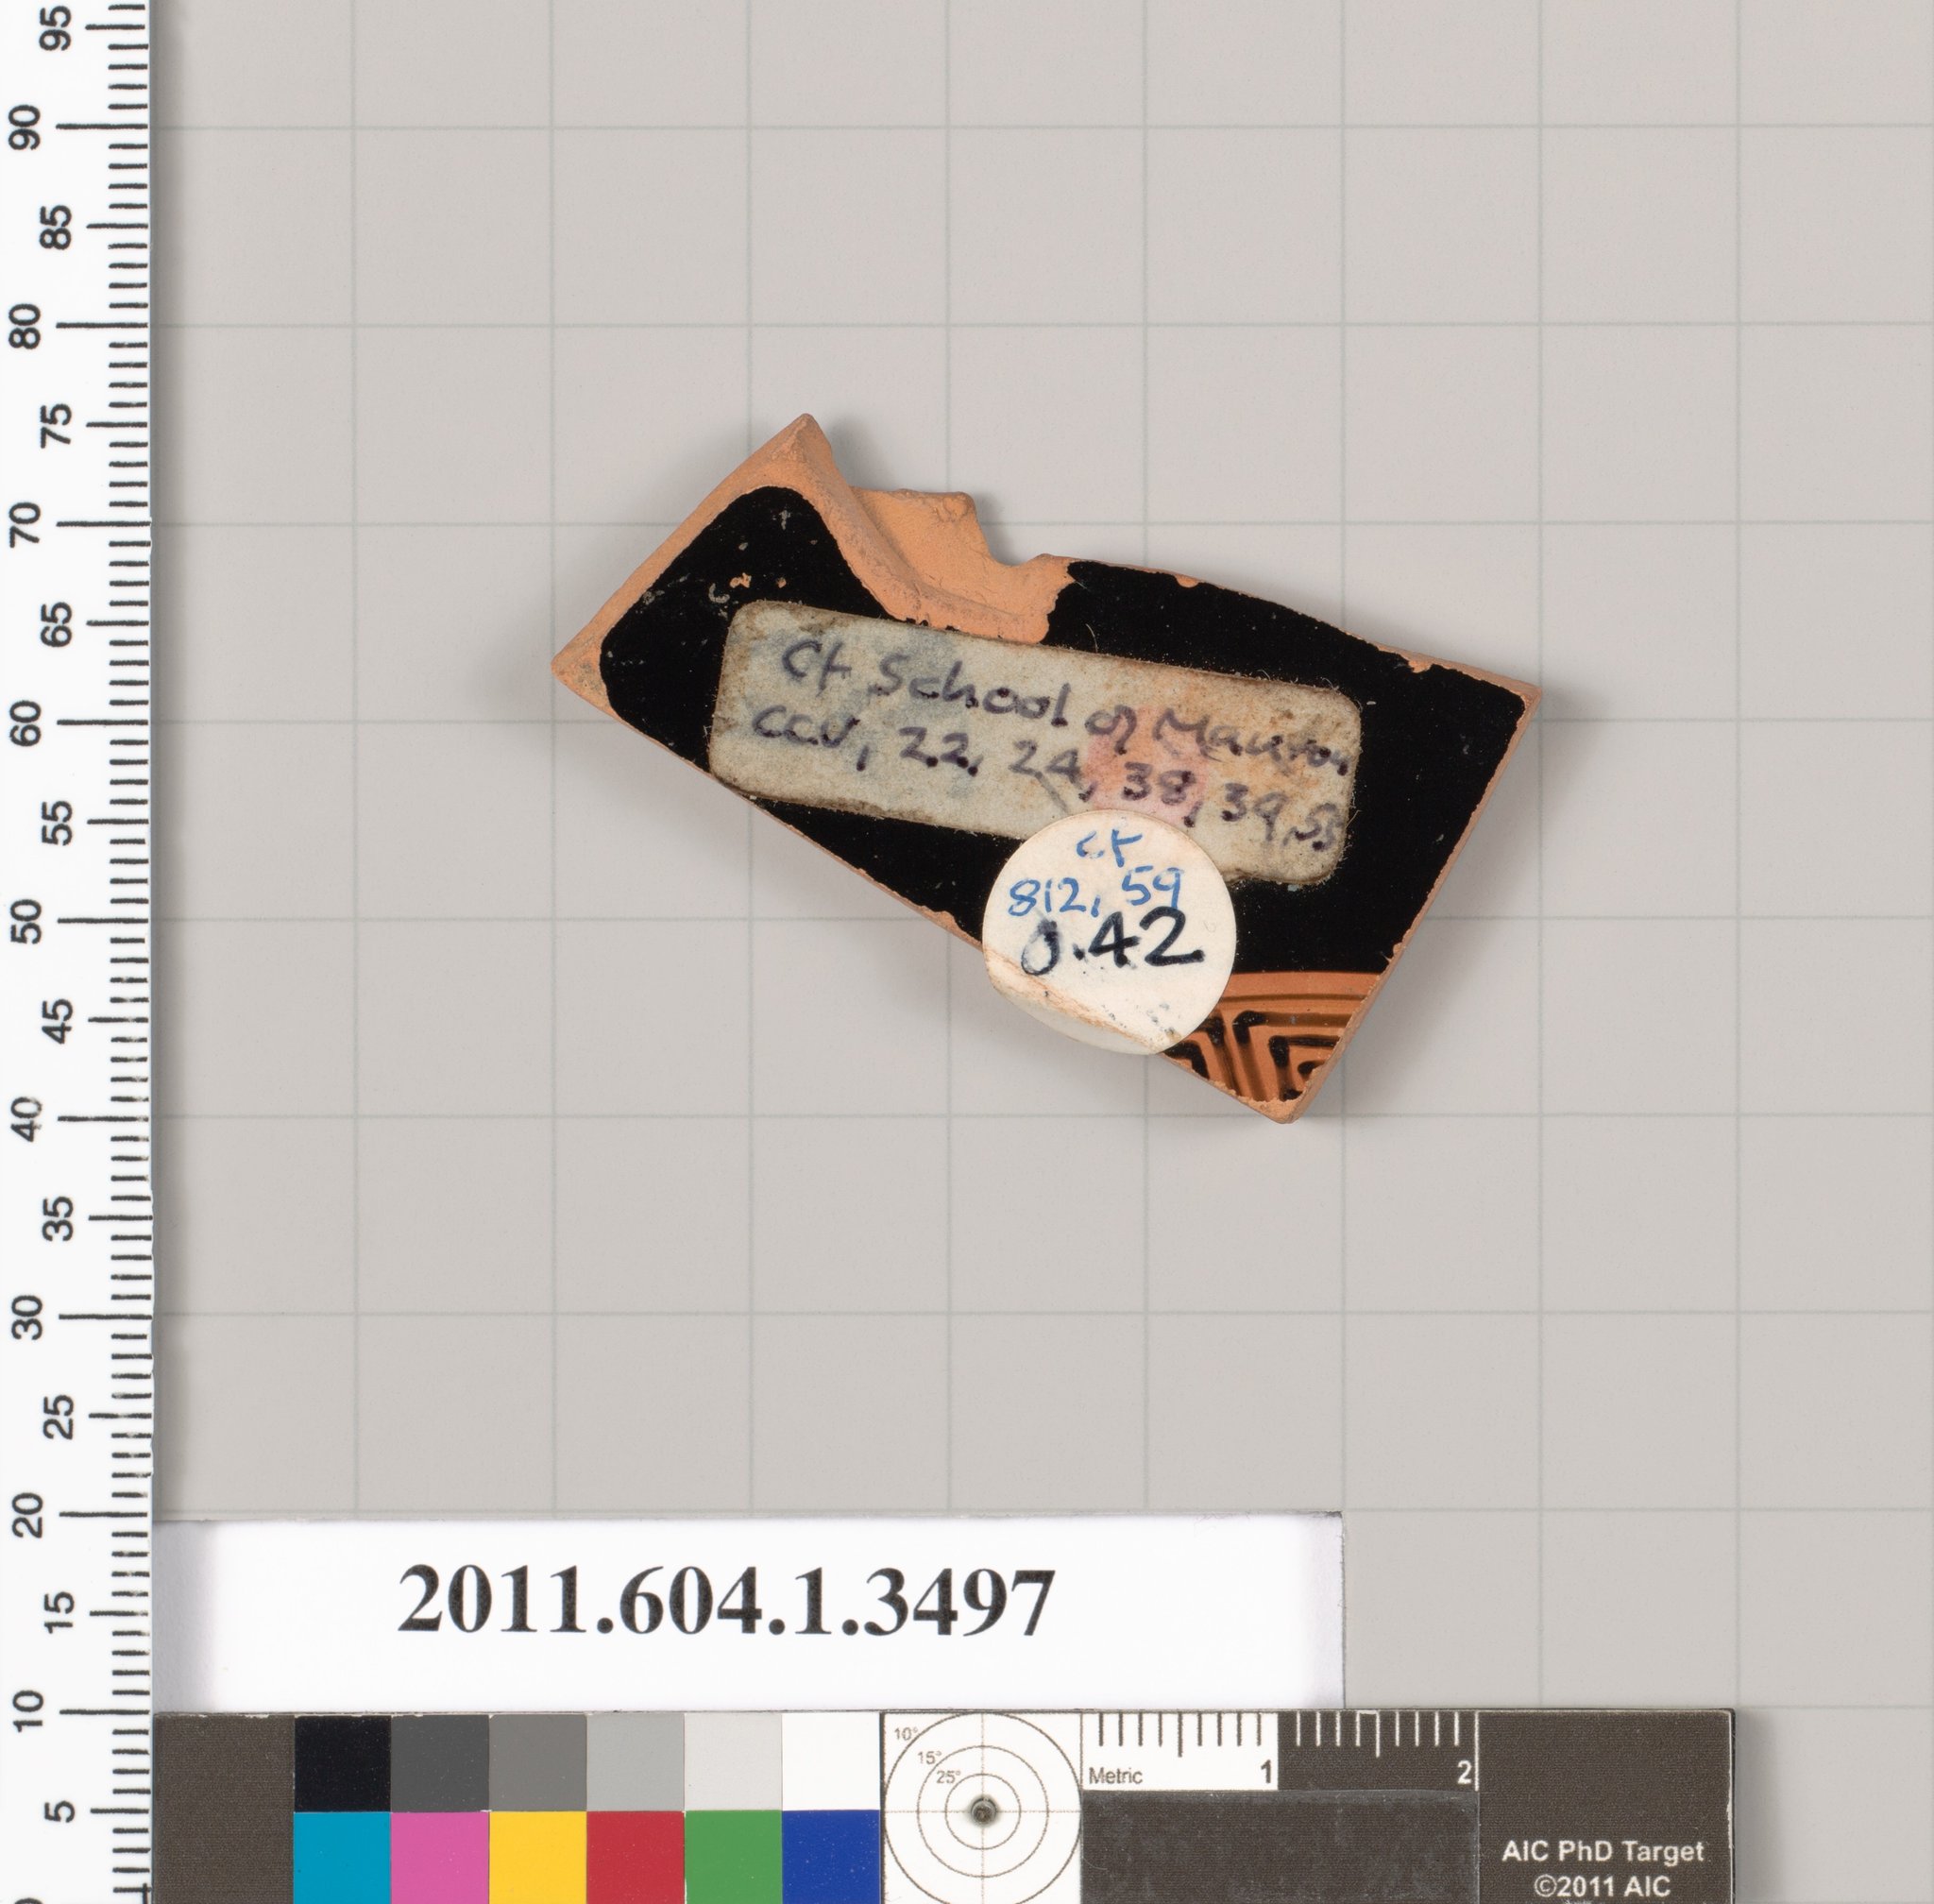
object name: kylix fragment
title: Terracotta fragment of a kylix (drinking cup)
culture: greek, attic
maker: makron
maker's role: artist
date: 490-480 BCE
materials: terracotta